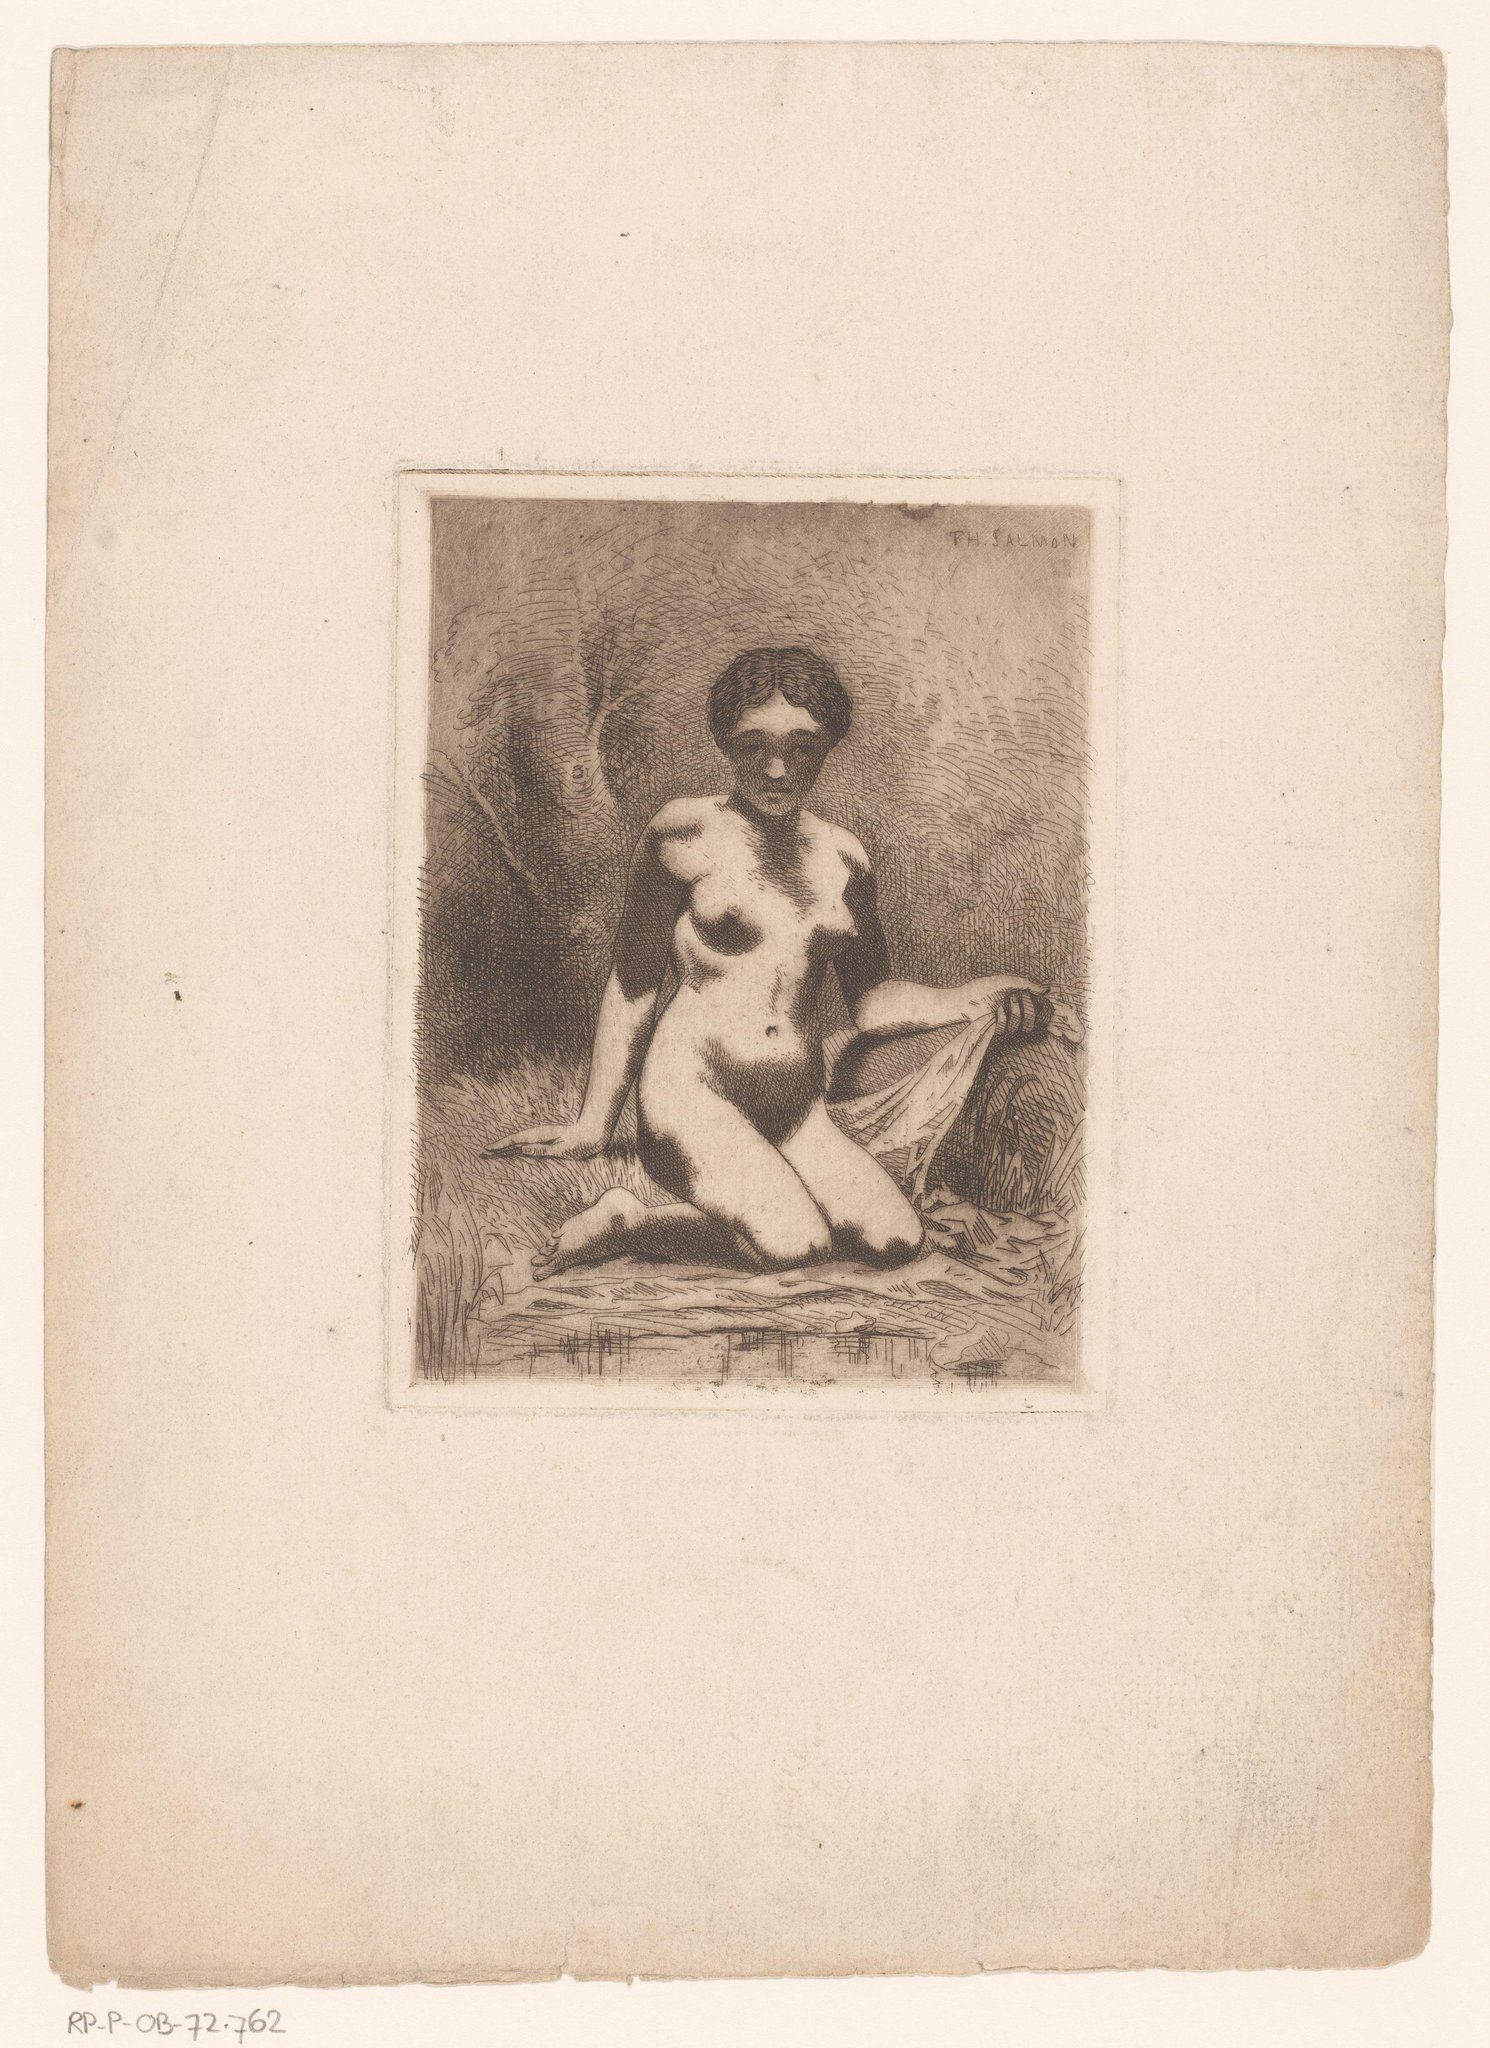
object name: print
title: Knielende naakte vrouw aan de waterkant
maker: théodore frédéric salmon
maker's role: print maker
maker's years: 1811-1876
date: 1821-1876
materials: paper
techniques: drypoint, etching, intaglio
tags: adult woman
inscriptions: collector's mark: Lugt 2228